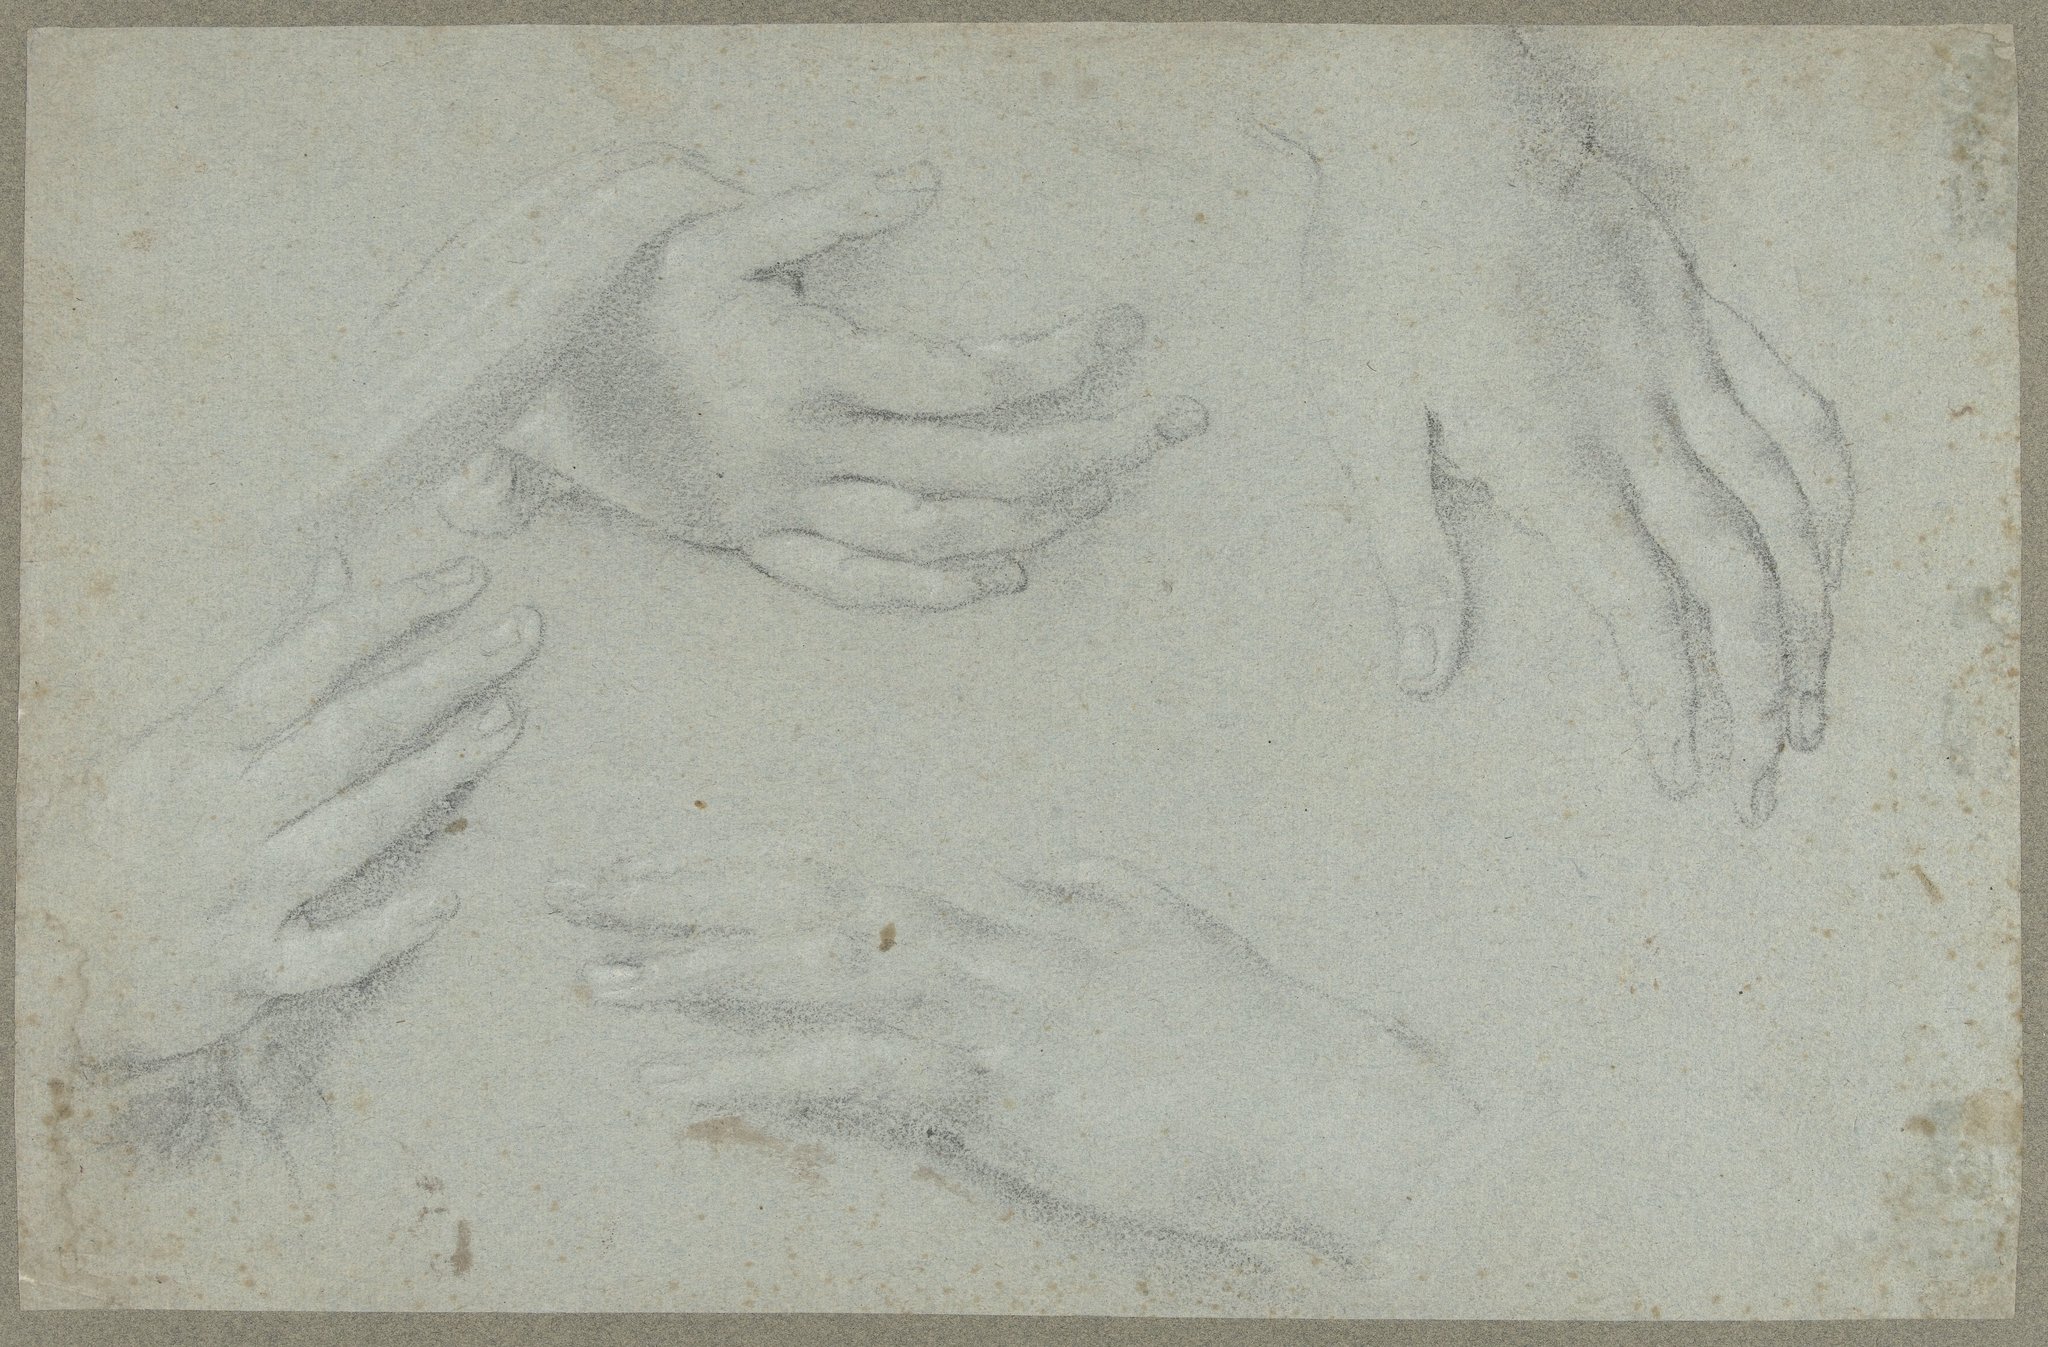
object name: drawing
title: Vier studies van een hand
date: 1626-1686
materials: chalk, paper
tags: hand